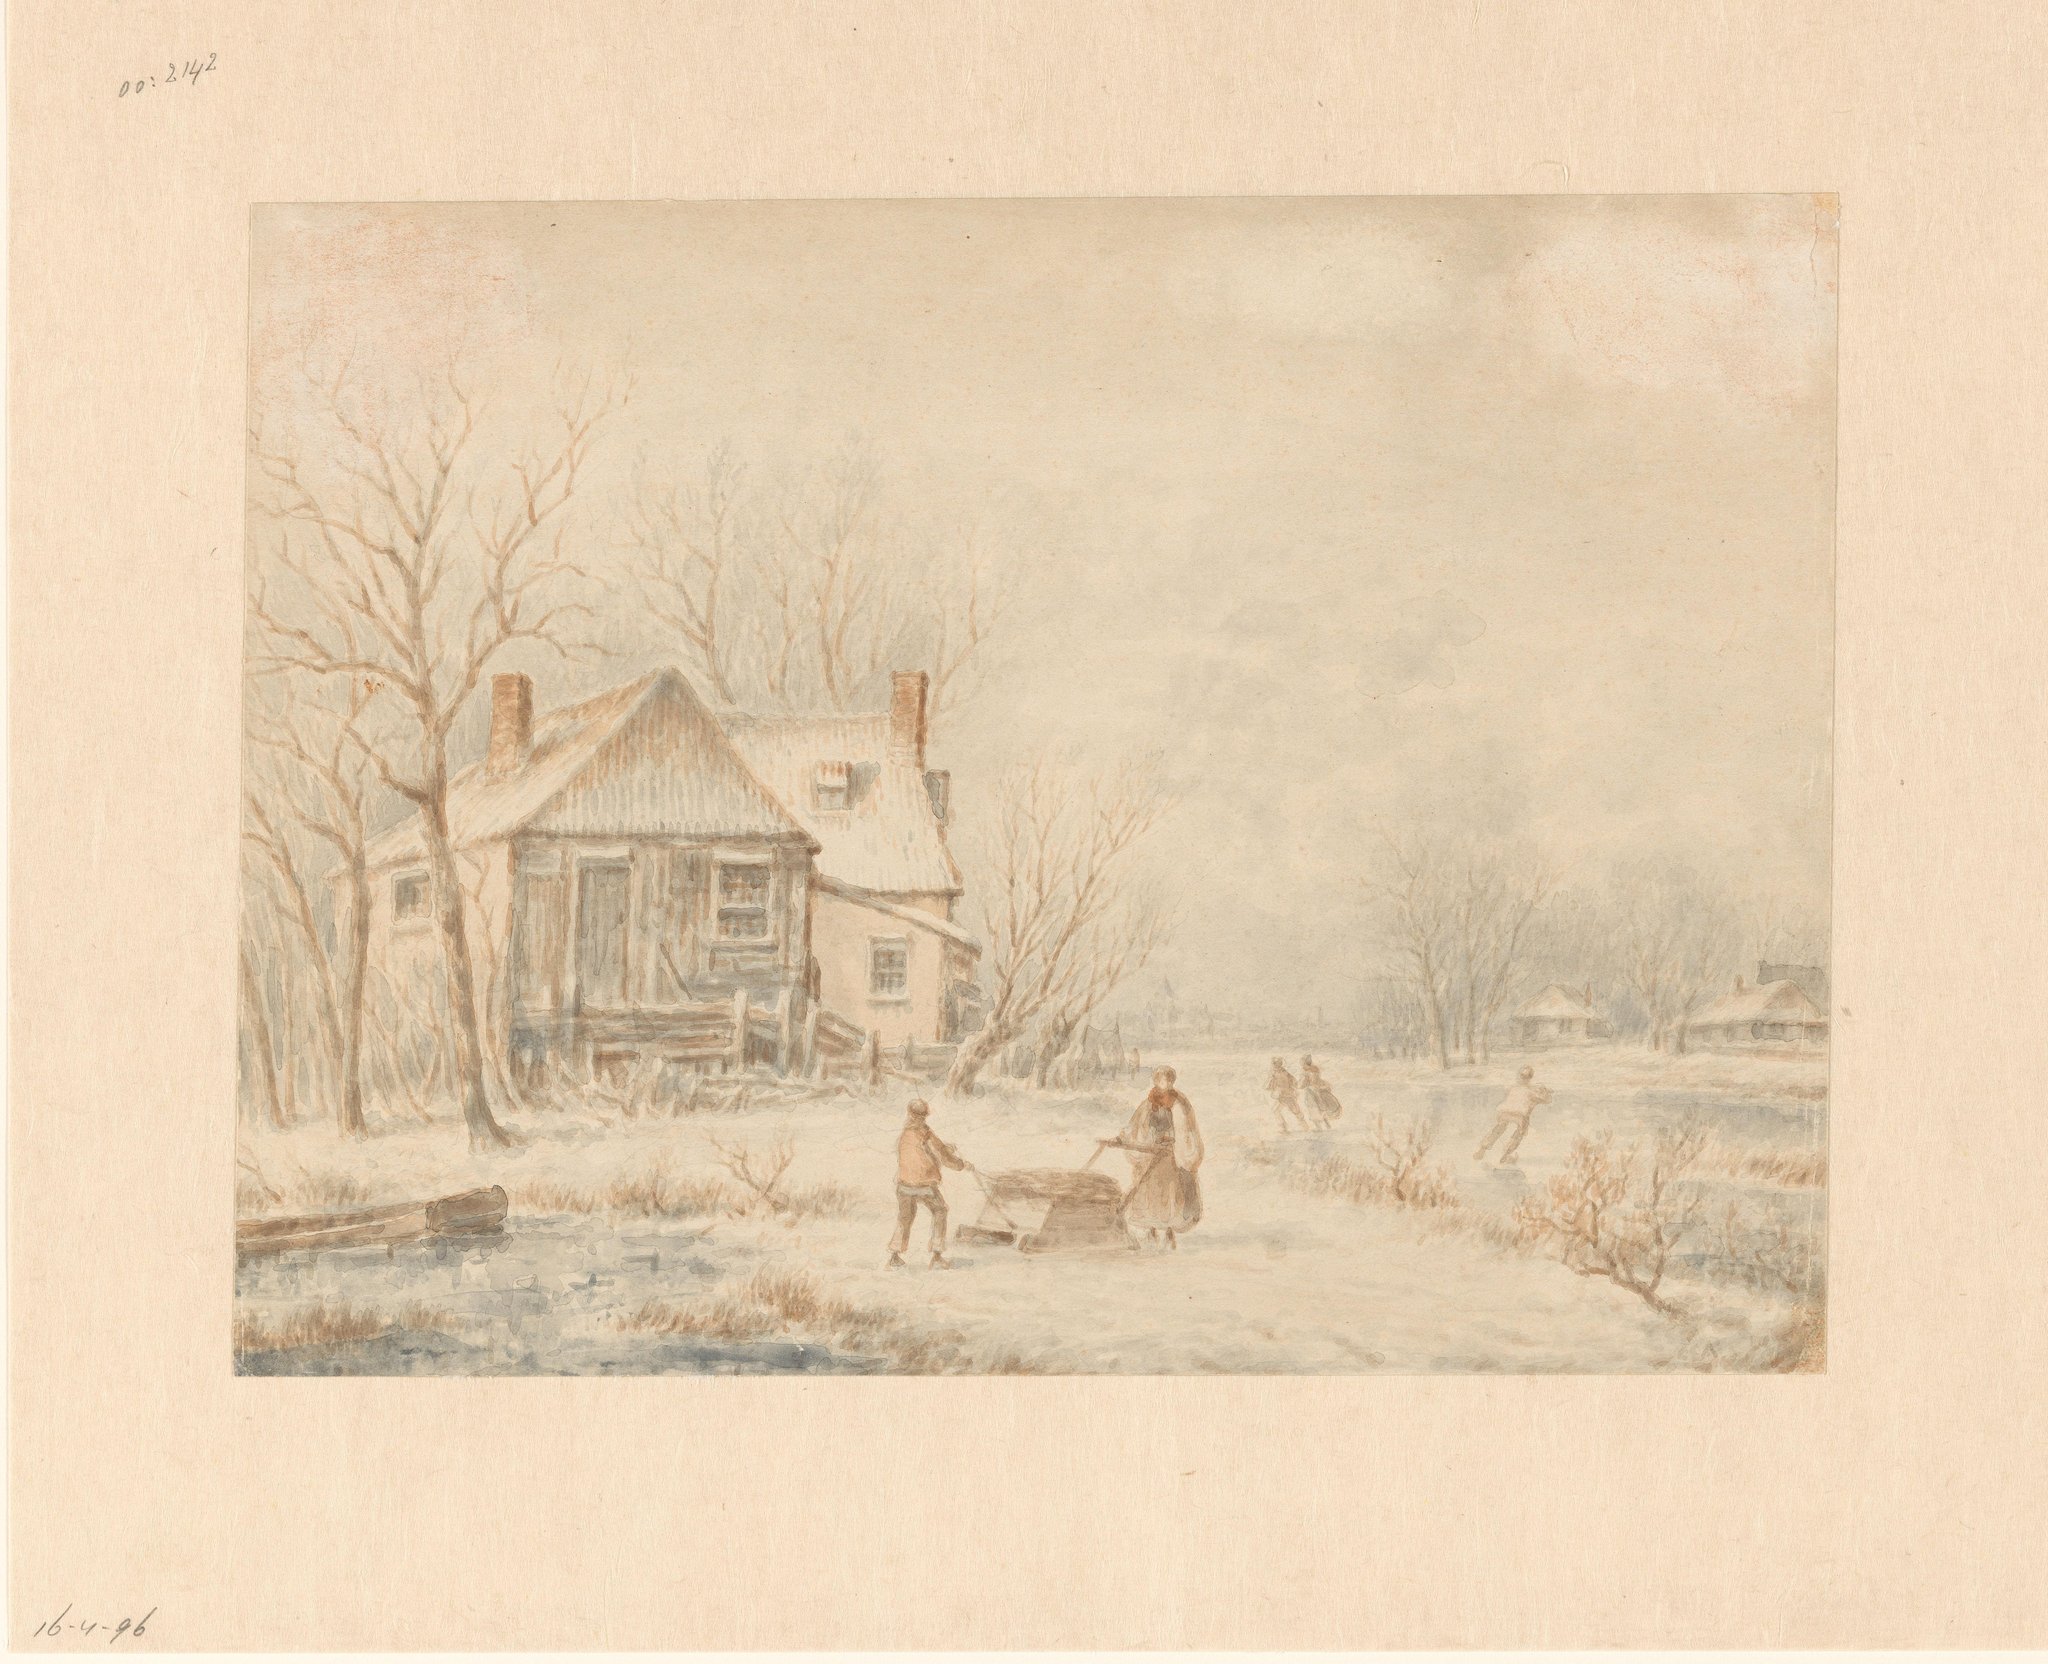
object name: drawing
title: Wintergezicht met twee personen met slee en enkele schaatsers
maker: Anonymous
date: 1800-1900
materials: paper, pencil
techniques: brush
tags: winter sports, ice ~ freezing weather